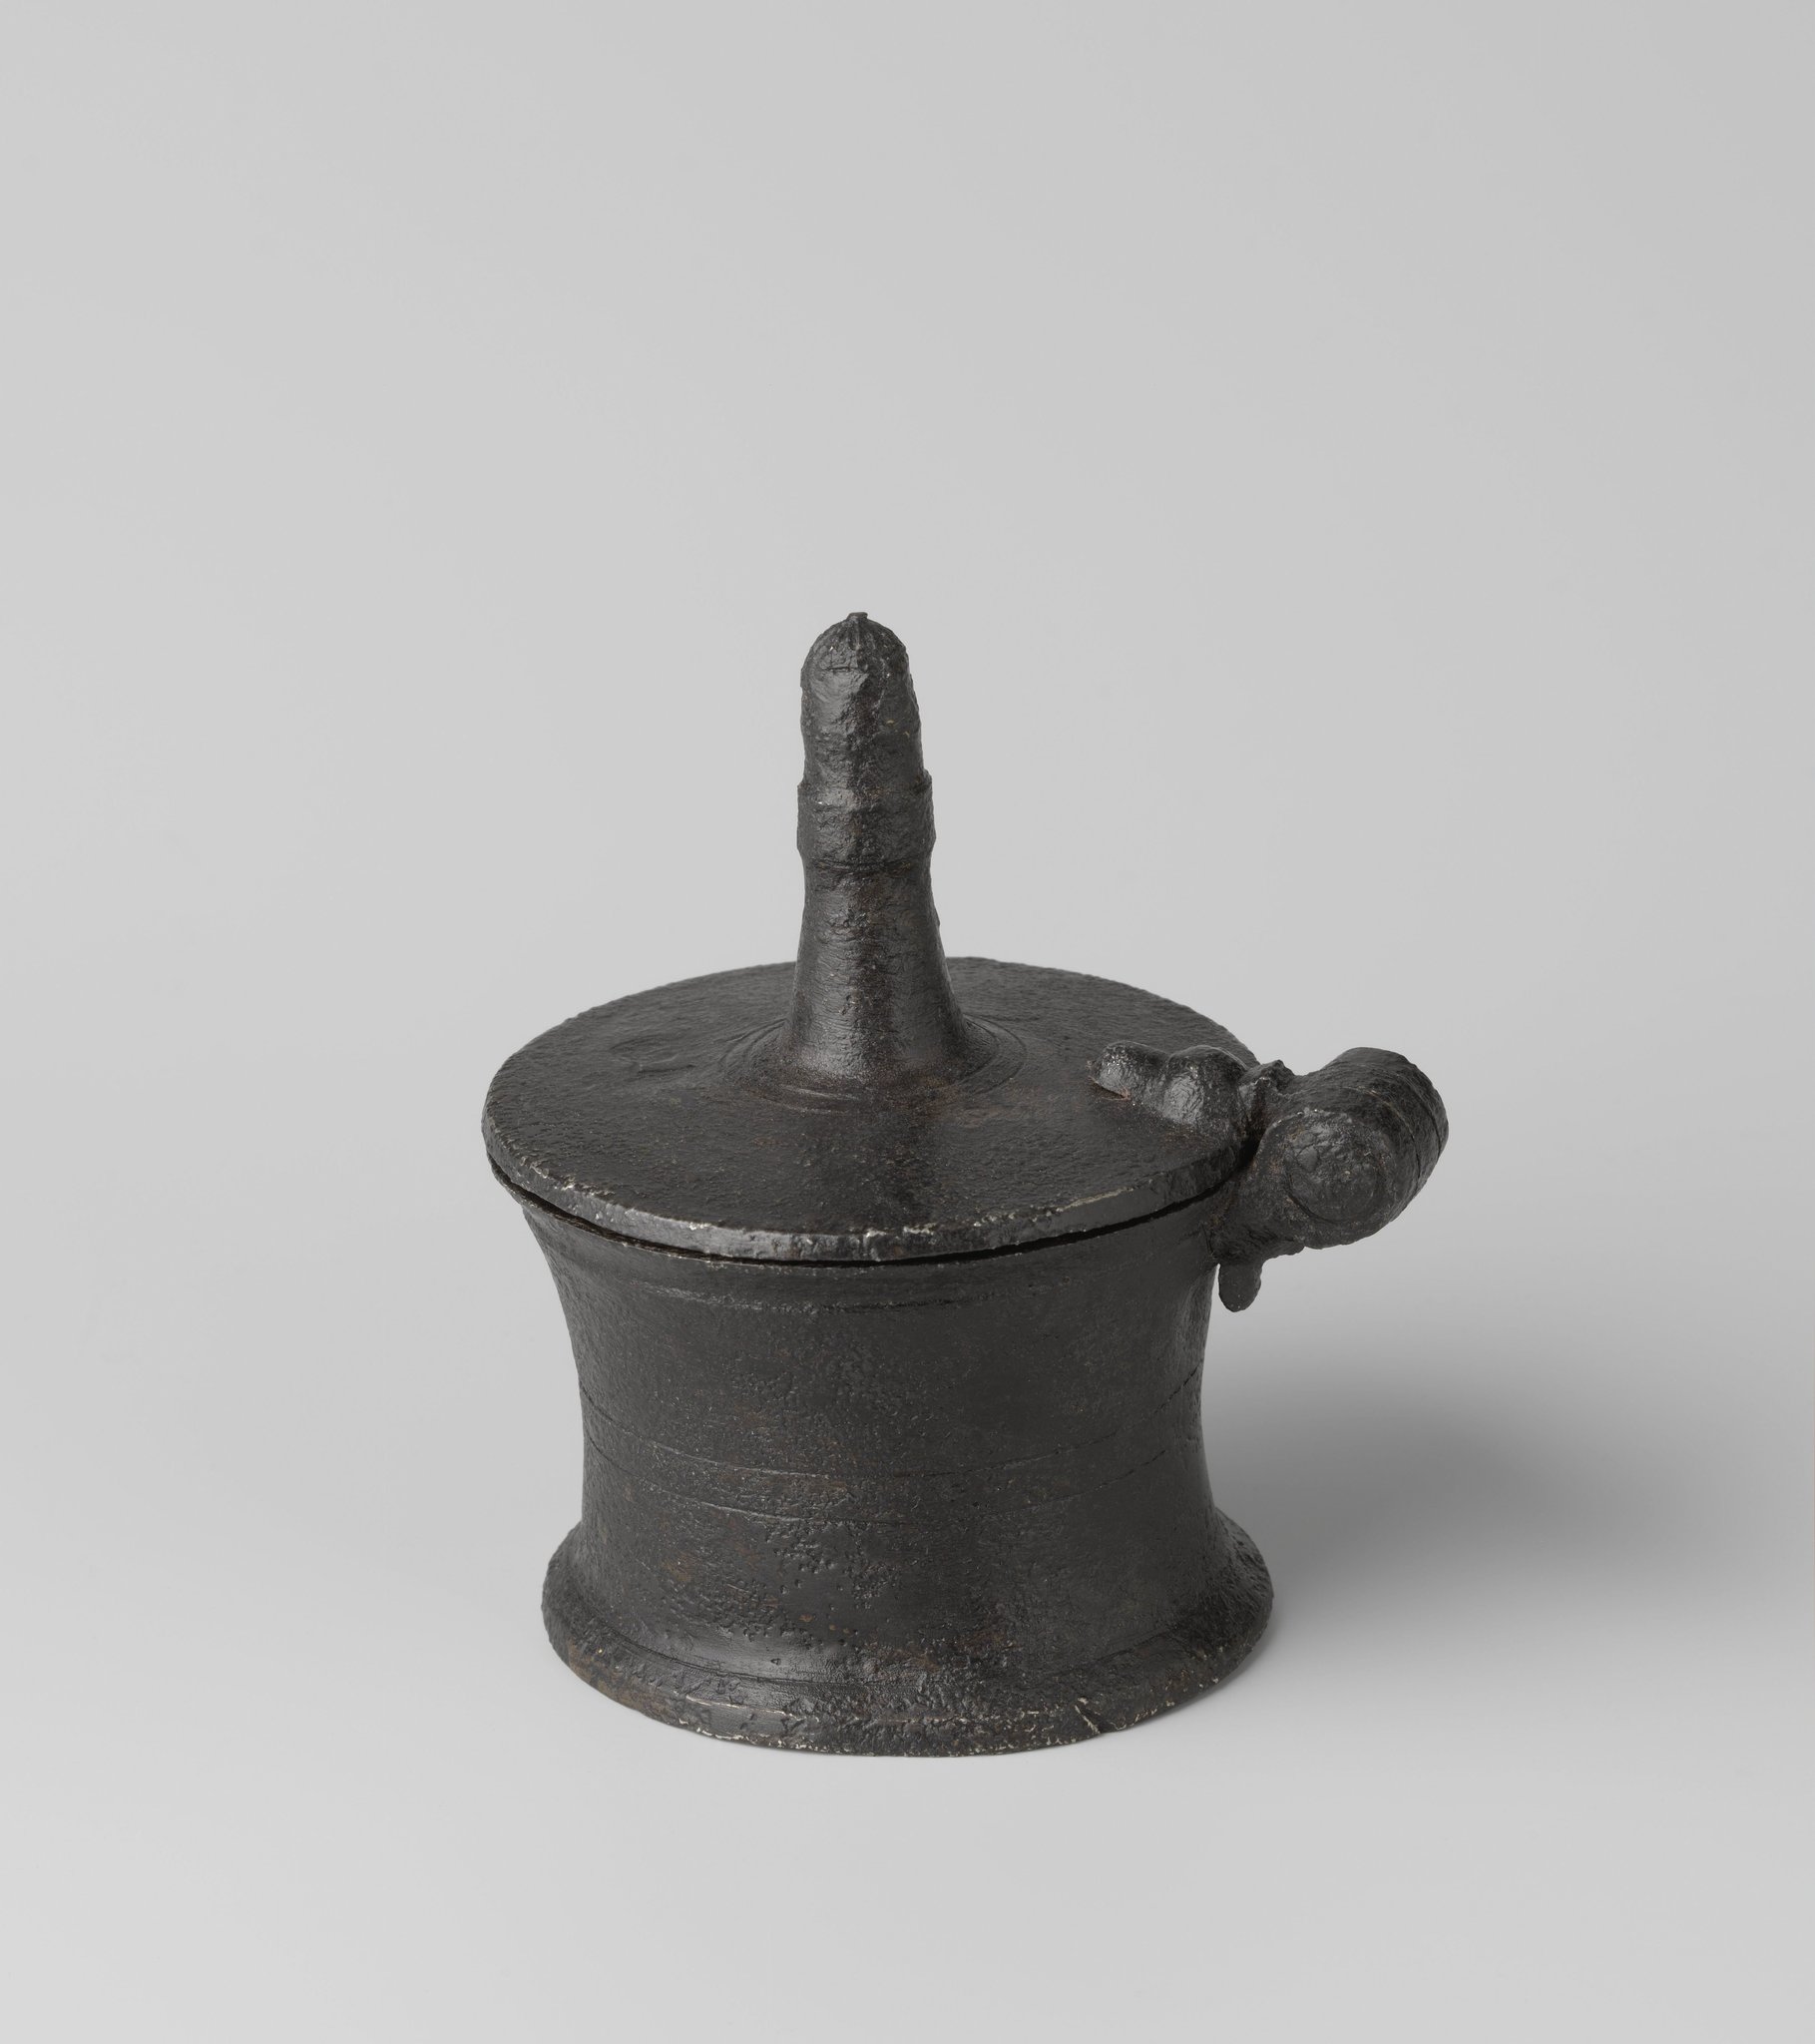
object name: salt condiment vessel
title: Zoutvat van tin met insigne op de bodem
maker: Anonymous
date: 1500-1600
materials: tin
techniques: casting, turning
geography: netherlands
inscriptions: quality mark, quality mark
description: Salt cellar. Pewter. Netherlands, 16th century.